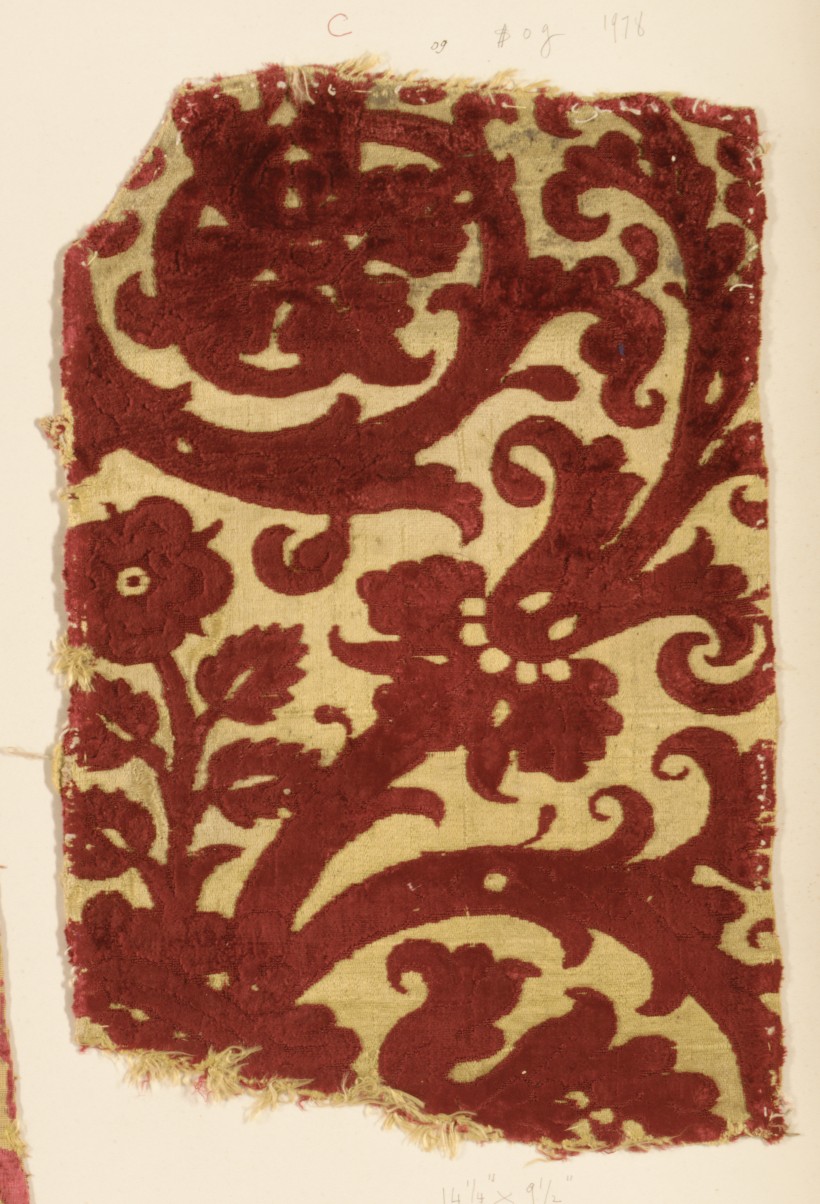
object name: fragment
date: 1601-1700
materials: silk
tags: flowers,leaves